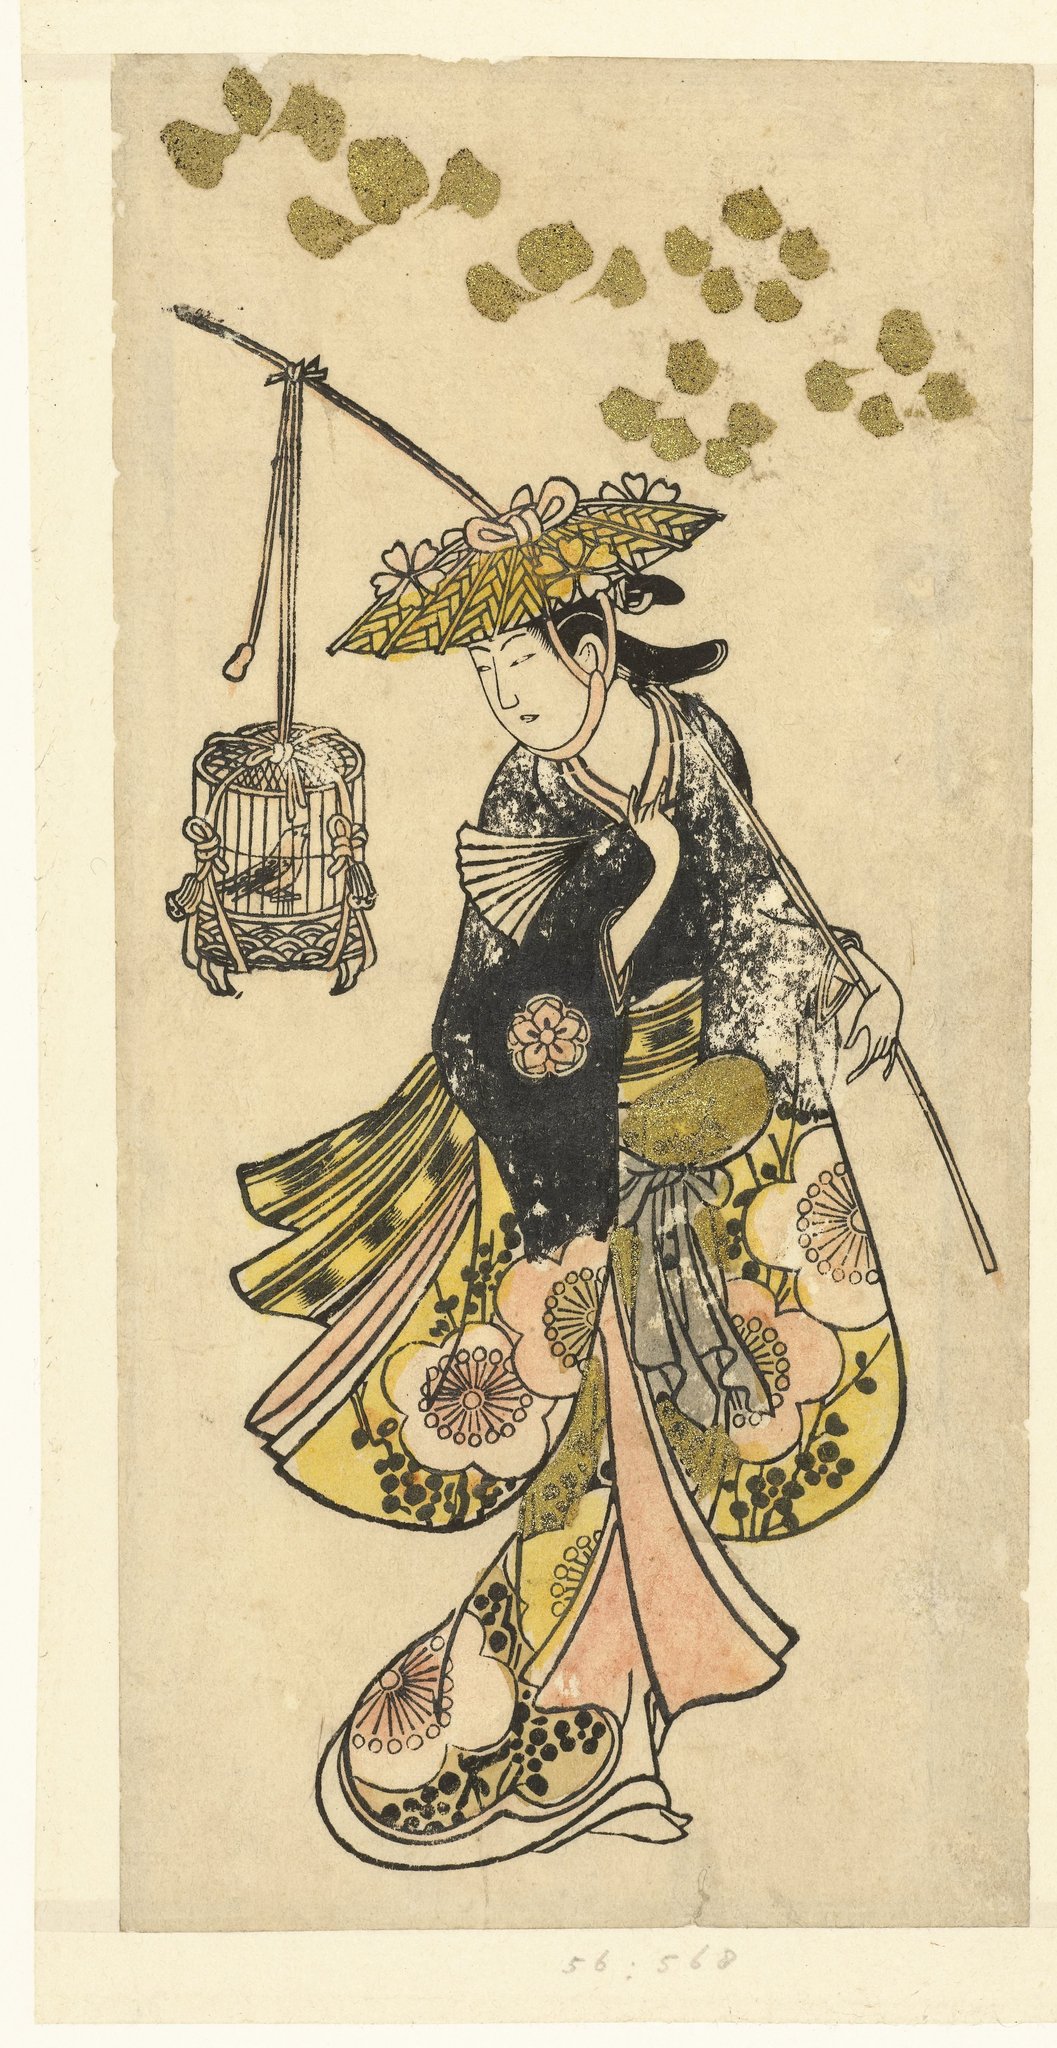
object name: print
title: Jonge vrouw met vogelkooi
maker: okumura toshinobu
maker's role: print maker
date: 1720-1730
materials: copper powder, paper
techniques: hand coloring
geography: japan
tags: bird in a cage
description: Vrouw met hoed en in kimono met patroon van grote pruimenbloesem, omkijkend naar vogelkooitje hangend aan stok welke ze over haar rechter schouder draagt; in haar linker hand een waaier.